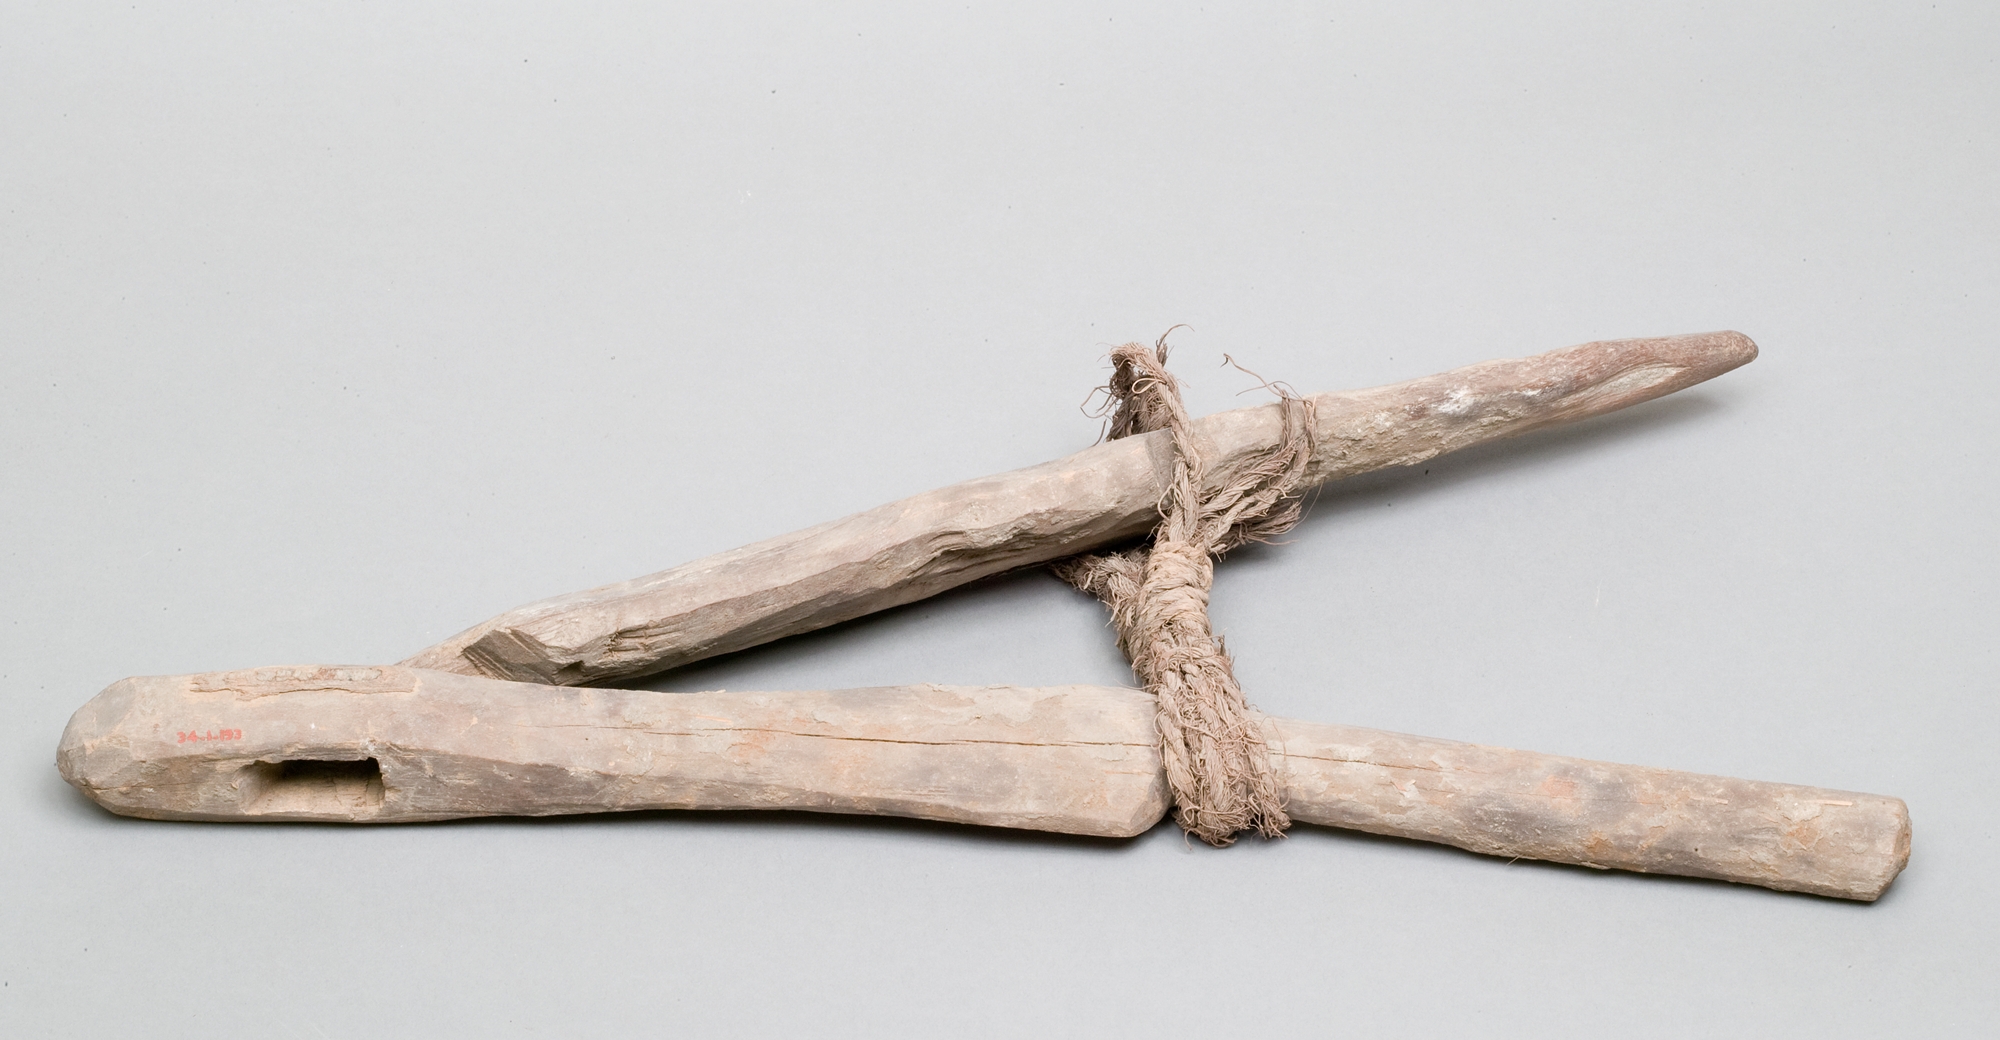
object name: hoe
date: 1961-1917 BCE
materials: wood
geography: egypt